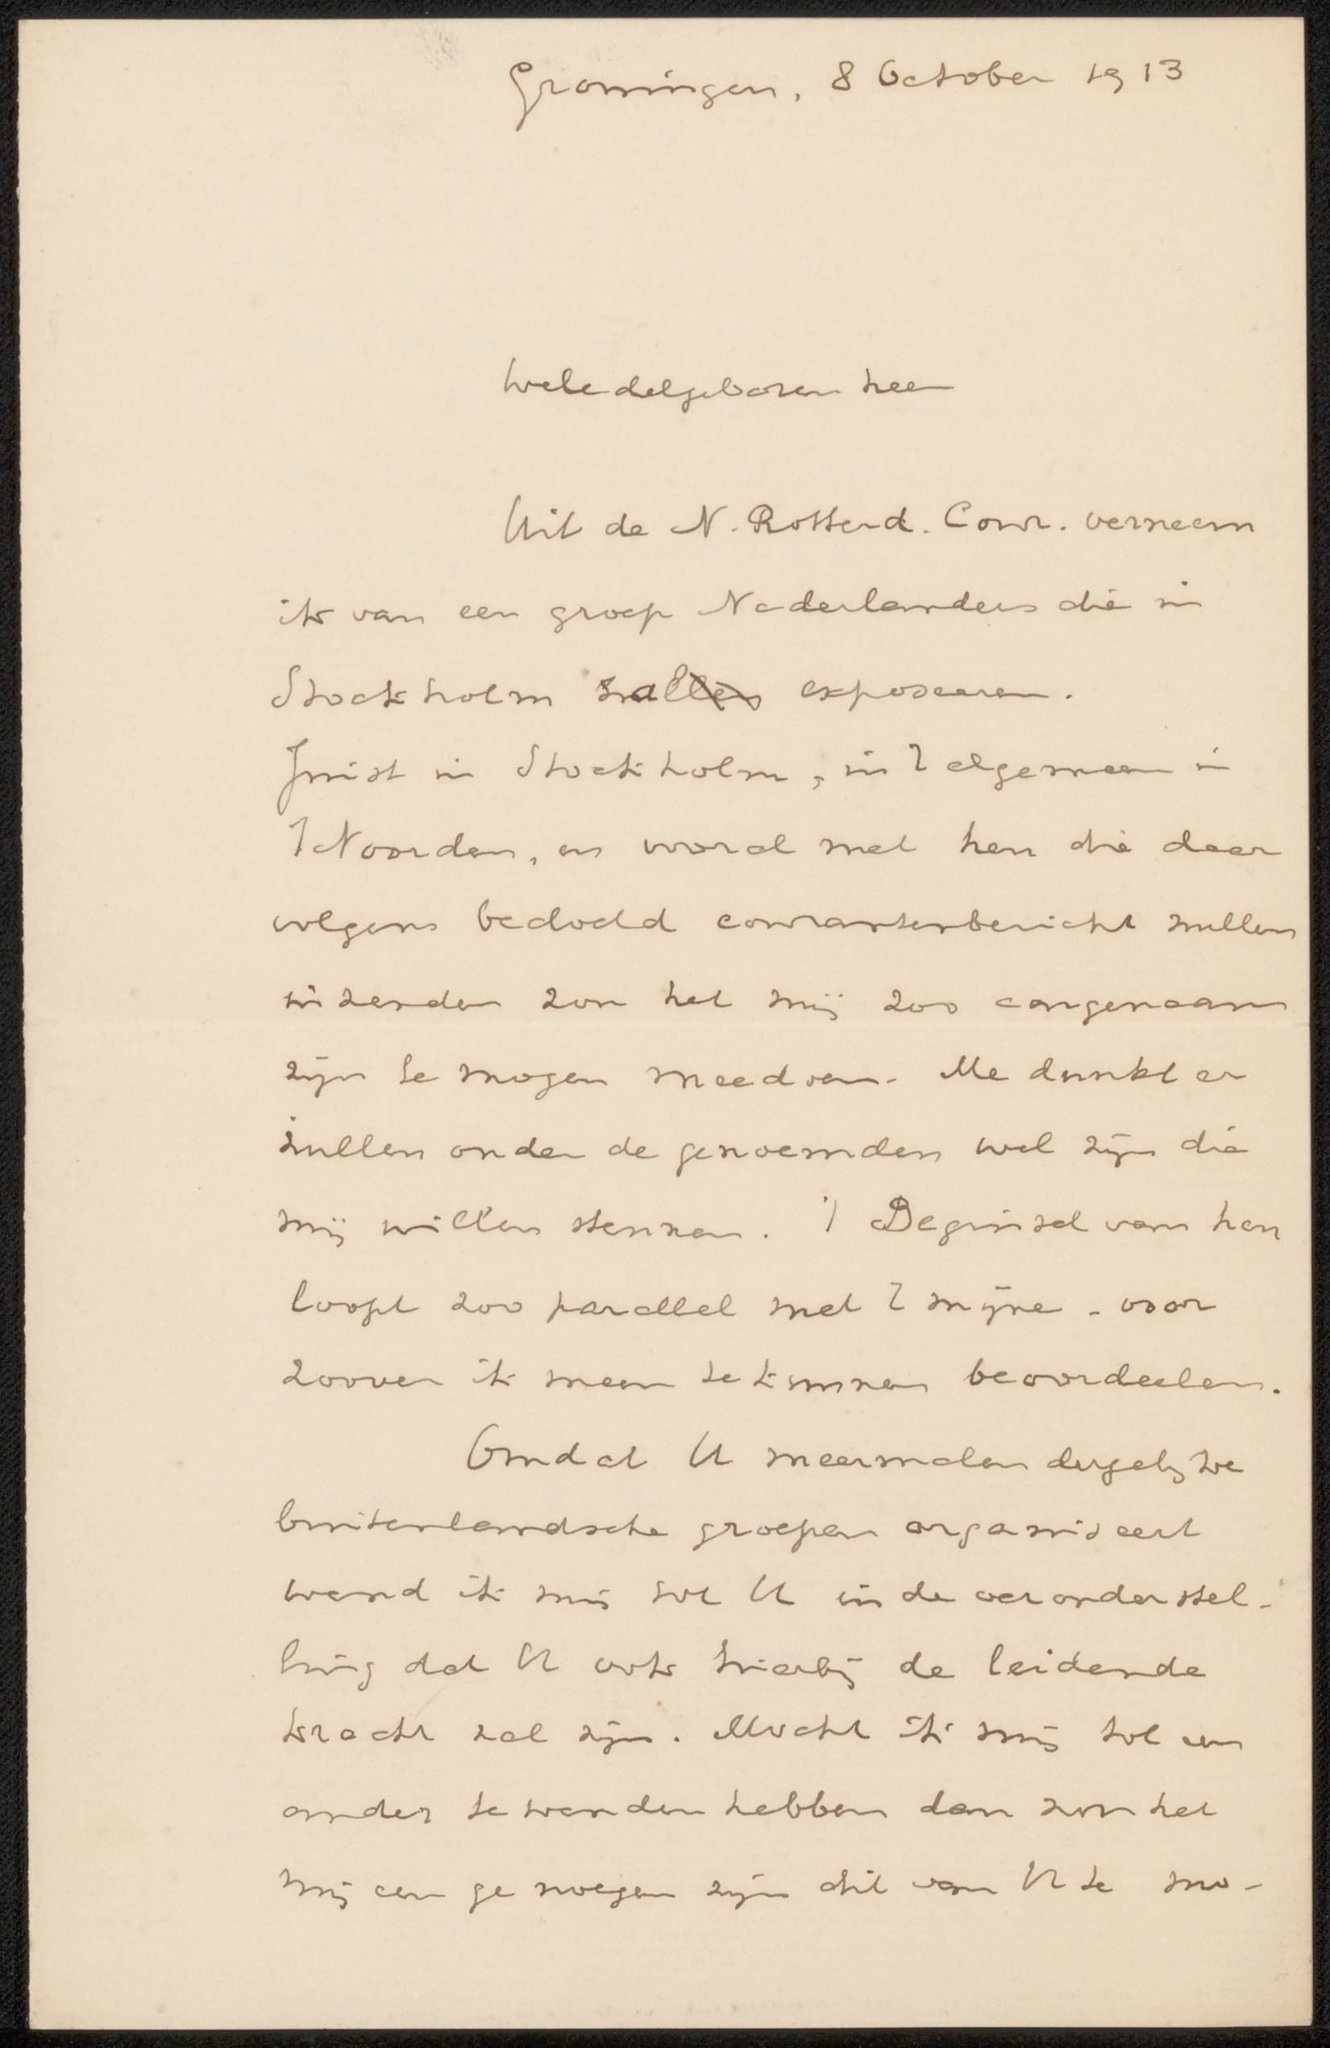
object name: letter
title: Brief aan Philip Zilcken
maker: dirk de vries lam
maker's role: draughtsman, painter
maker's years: 1869-1937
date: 1913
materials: ink, paper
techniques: pen, writing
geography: groningen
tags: the hague, philip zilcken, exhibition ~ art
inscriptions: collector's mark: ‘RPK’, watermark